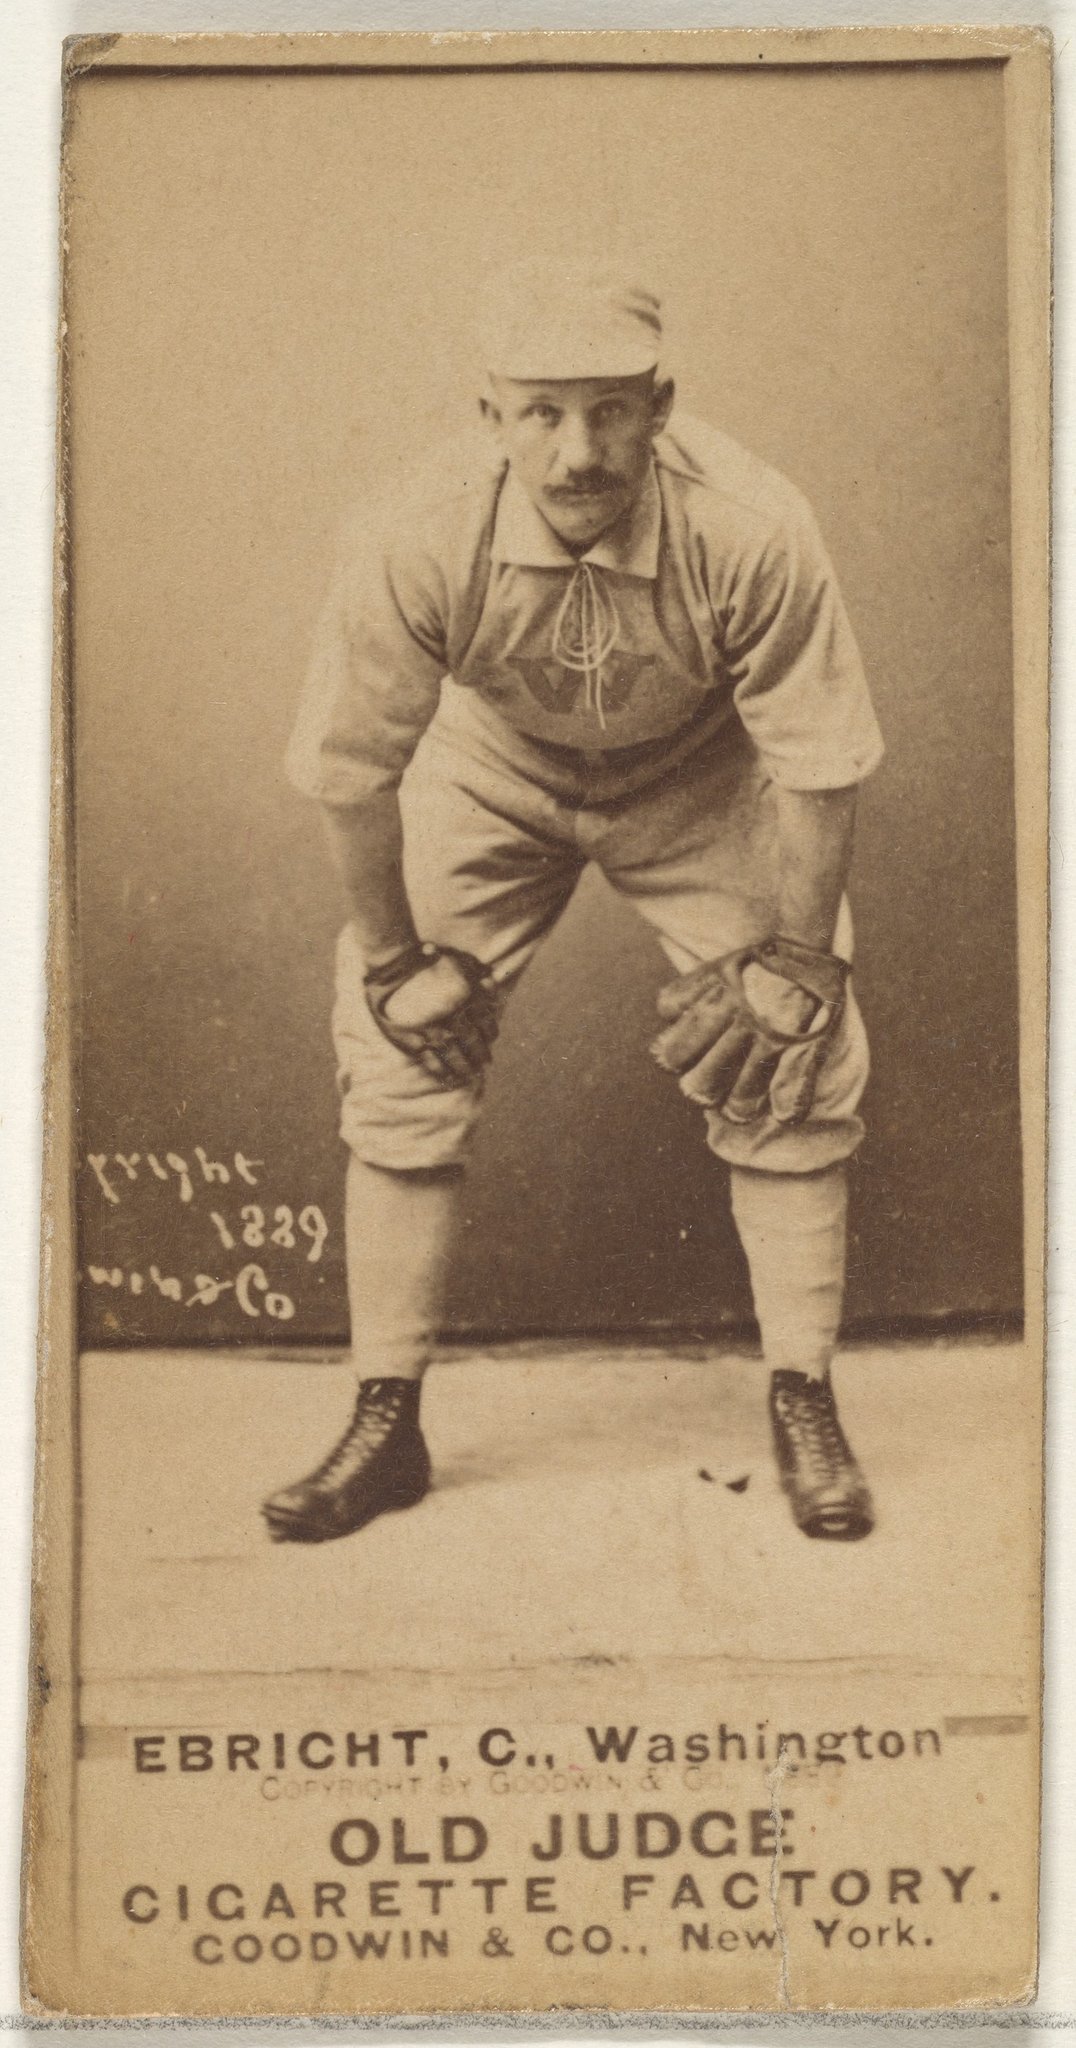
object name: baseball card, photograph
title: Hiram "Hi" C. Ebright, Catcher, Washington Nationals, from the Old Judge series (N172) for Old Judge Cigarettes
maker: goodwin & company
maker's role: publisher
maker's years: 1850-1950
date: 1889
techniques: albumen silver print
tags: men,portraits,baseball,athletes